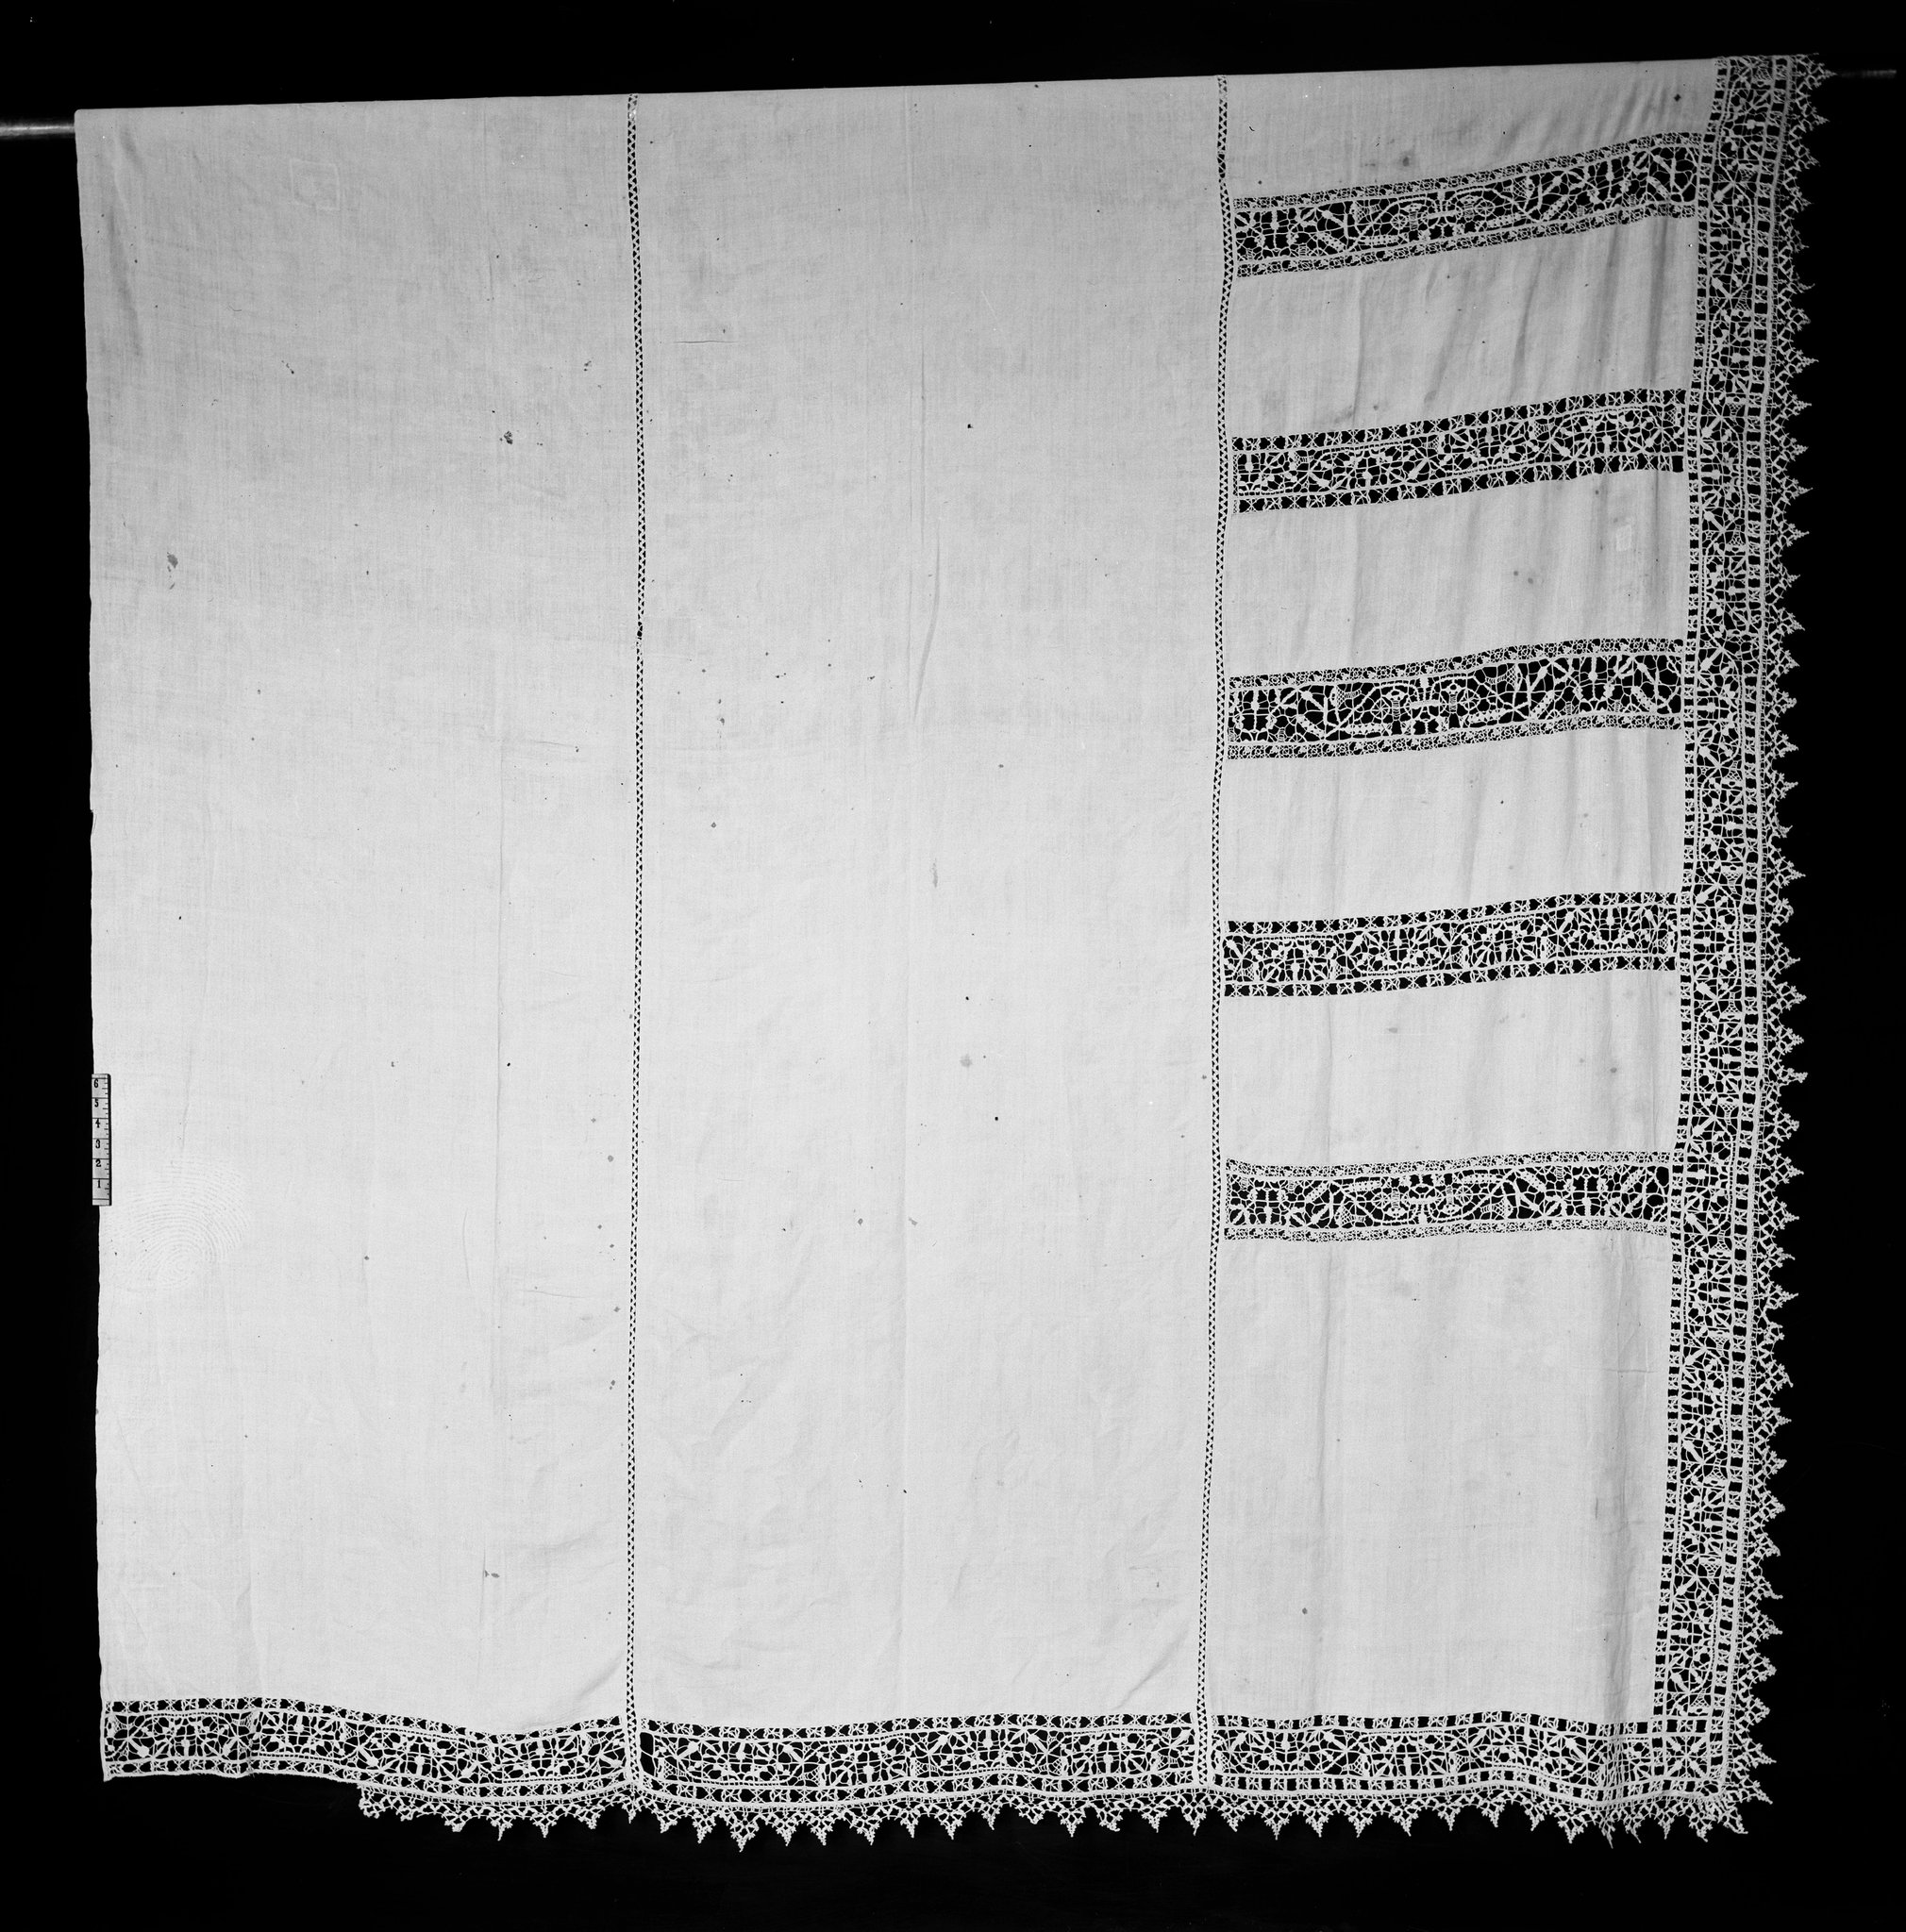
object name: panel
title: Altar cloth or hanging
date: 1501-1600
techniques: lace